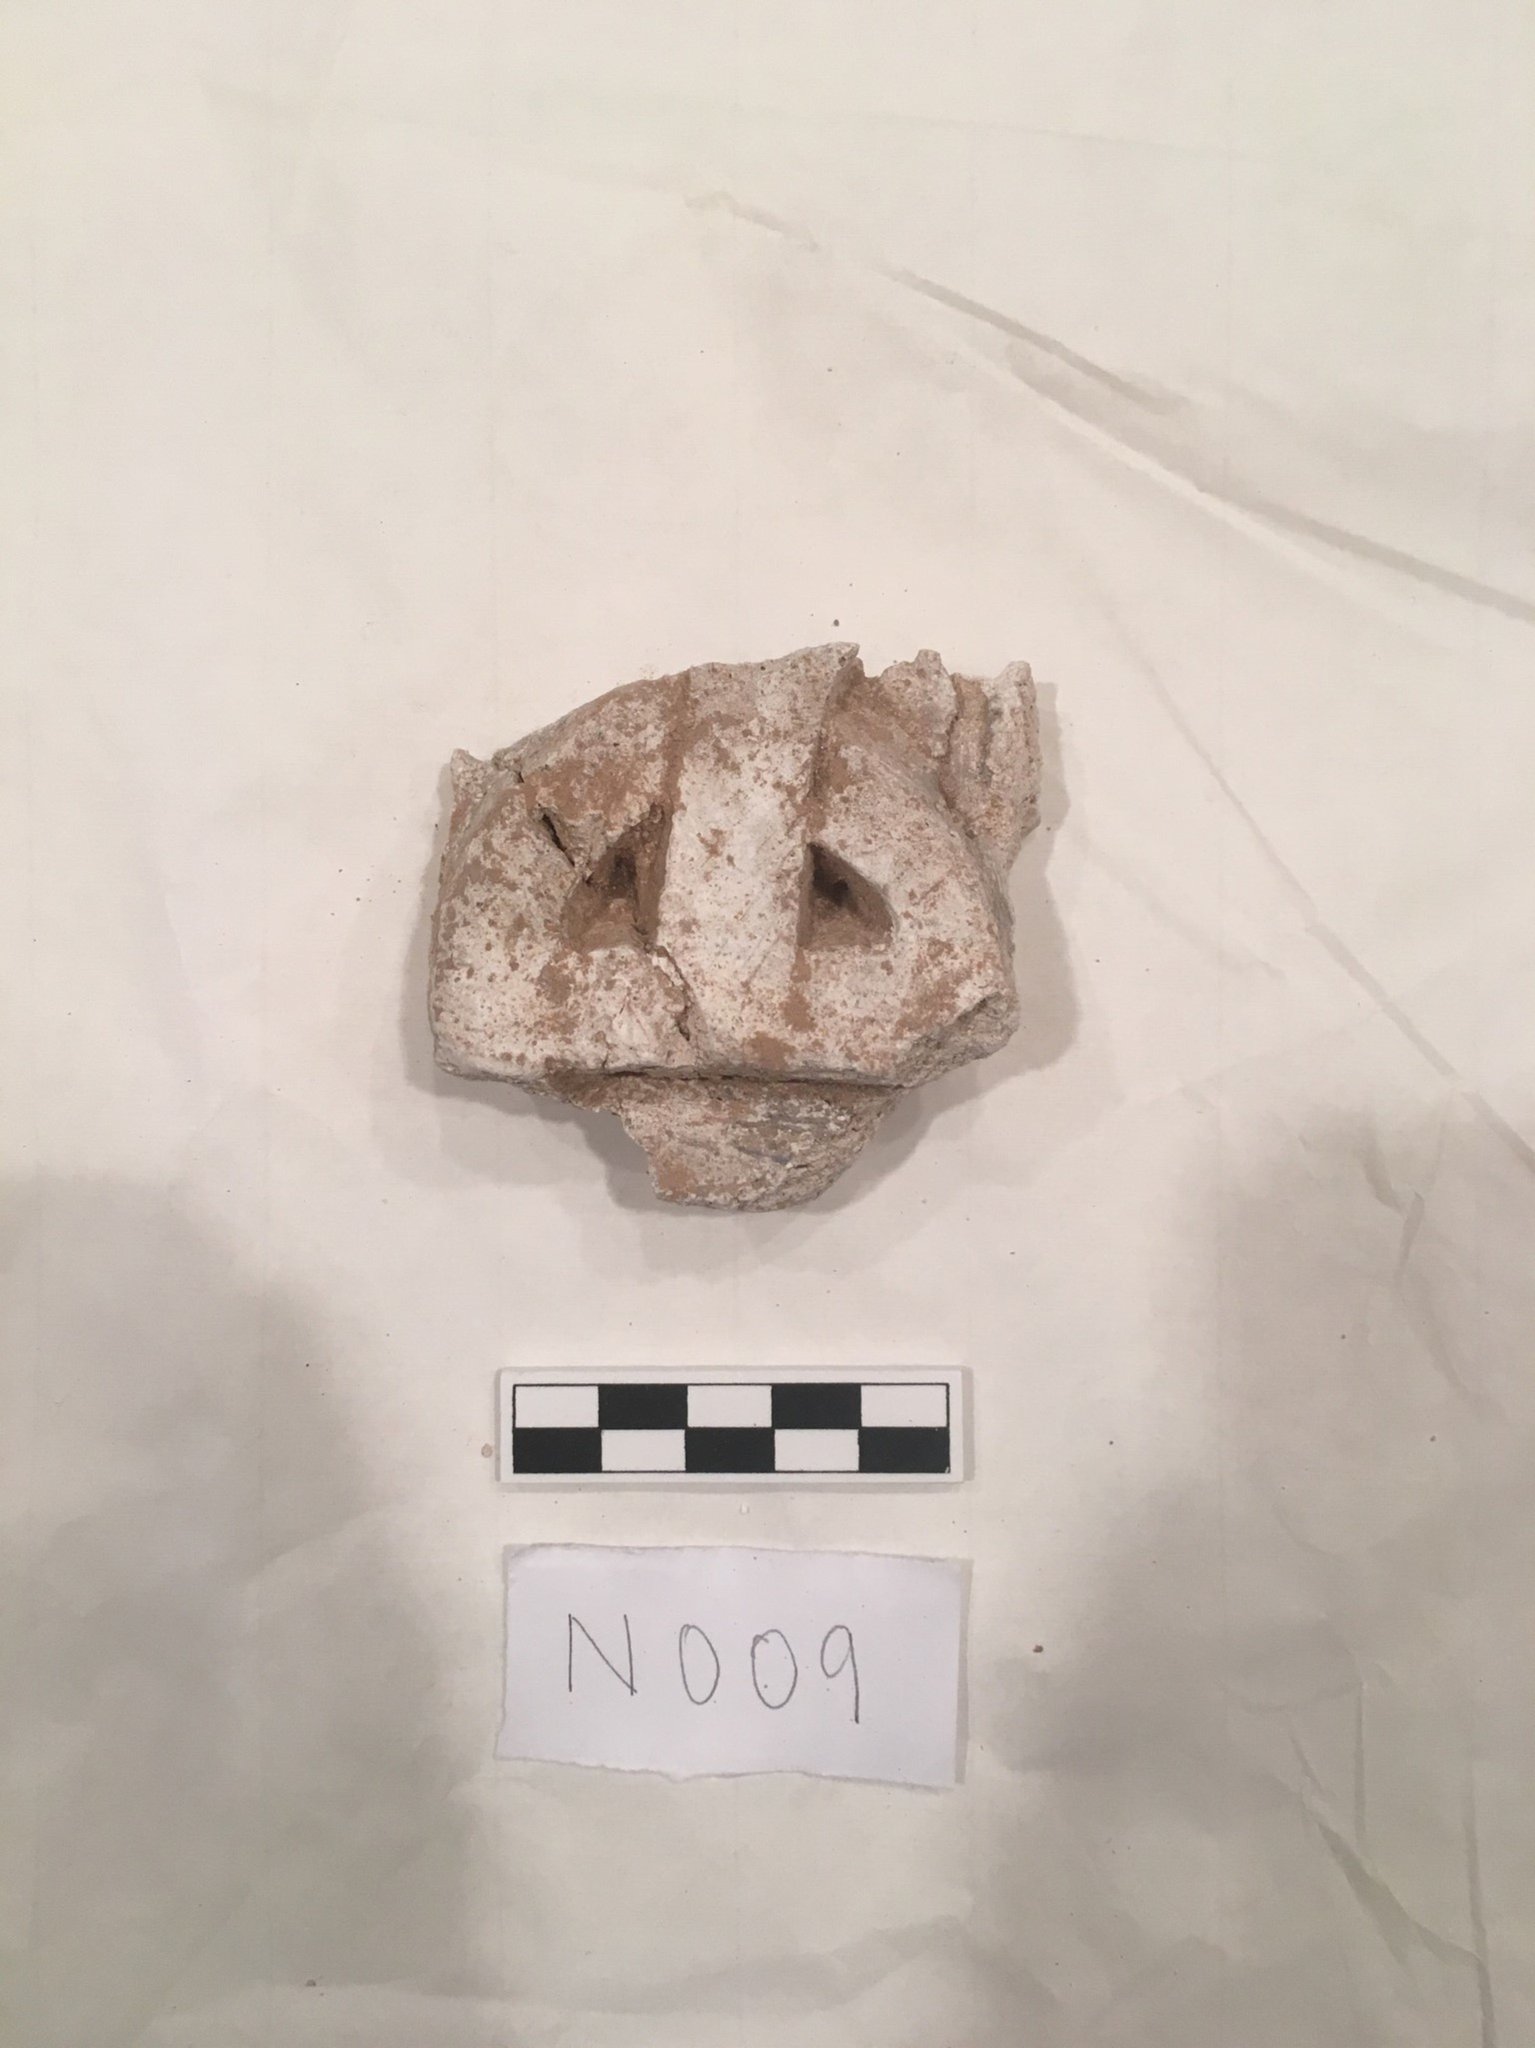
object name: fragment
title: Stucco Fragment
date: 701-1200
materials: plaster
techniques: carving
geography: iran